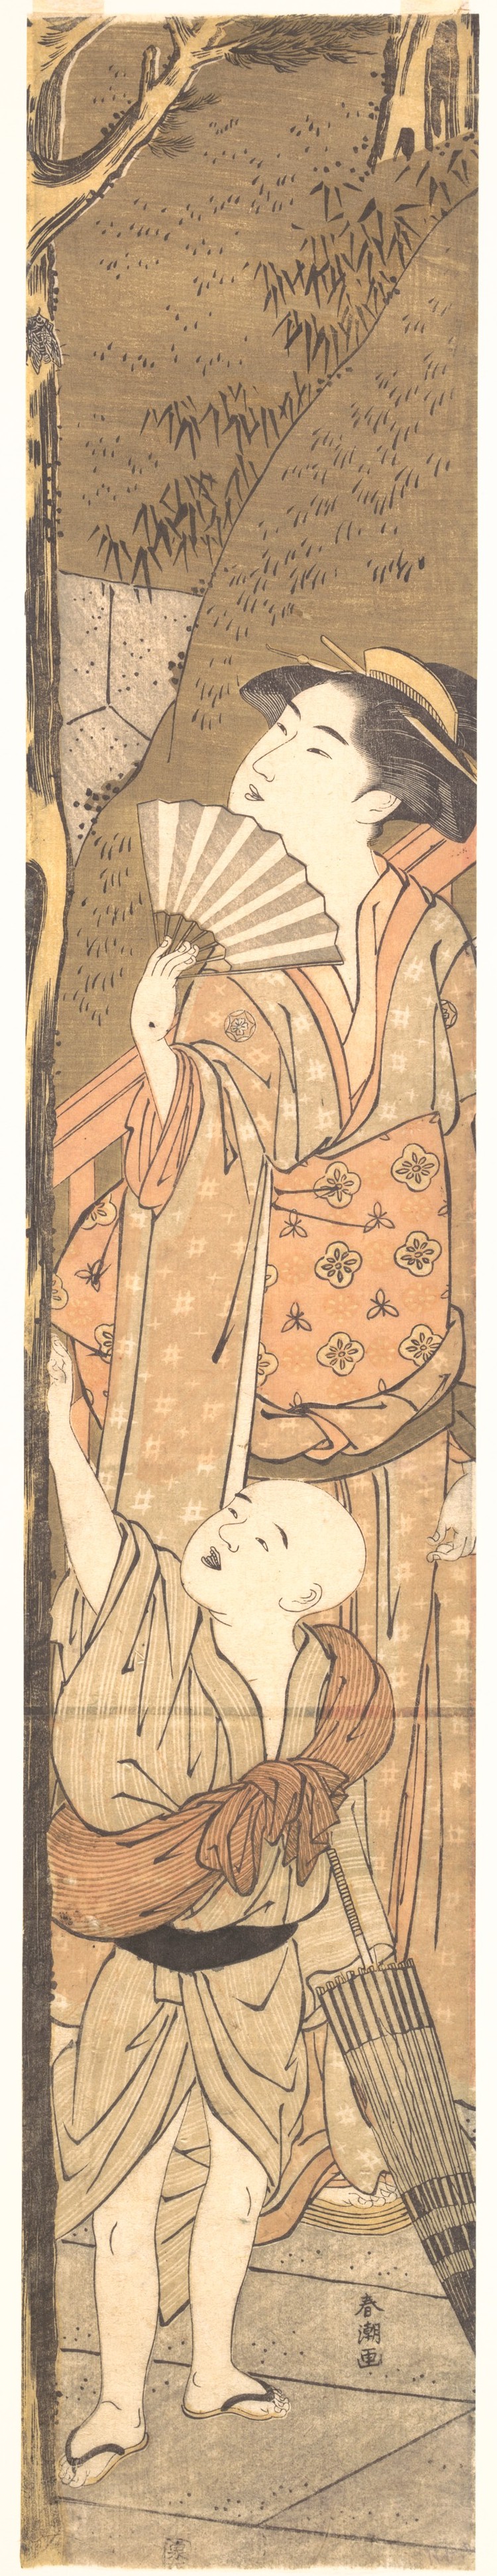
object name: print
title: Woman and Small Boy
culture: japanese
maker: katsukawa shunchō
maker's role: artist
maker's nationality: japanese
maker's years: 1775-1795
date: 1780-1795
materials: ink, paper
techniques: woodblock print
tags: fans,boys,women